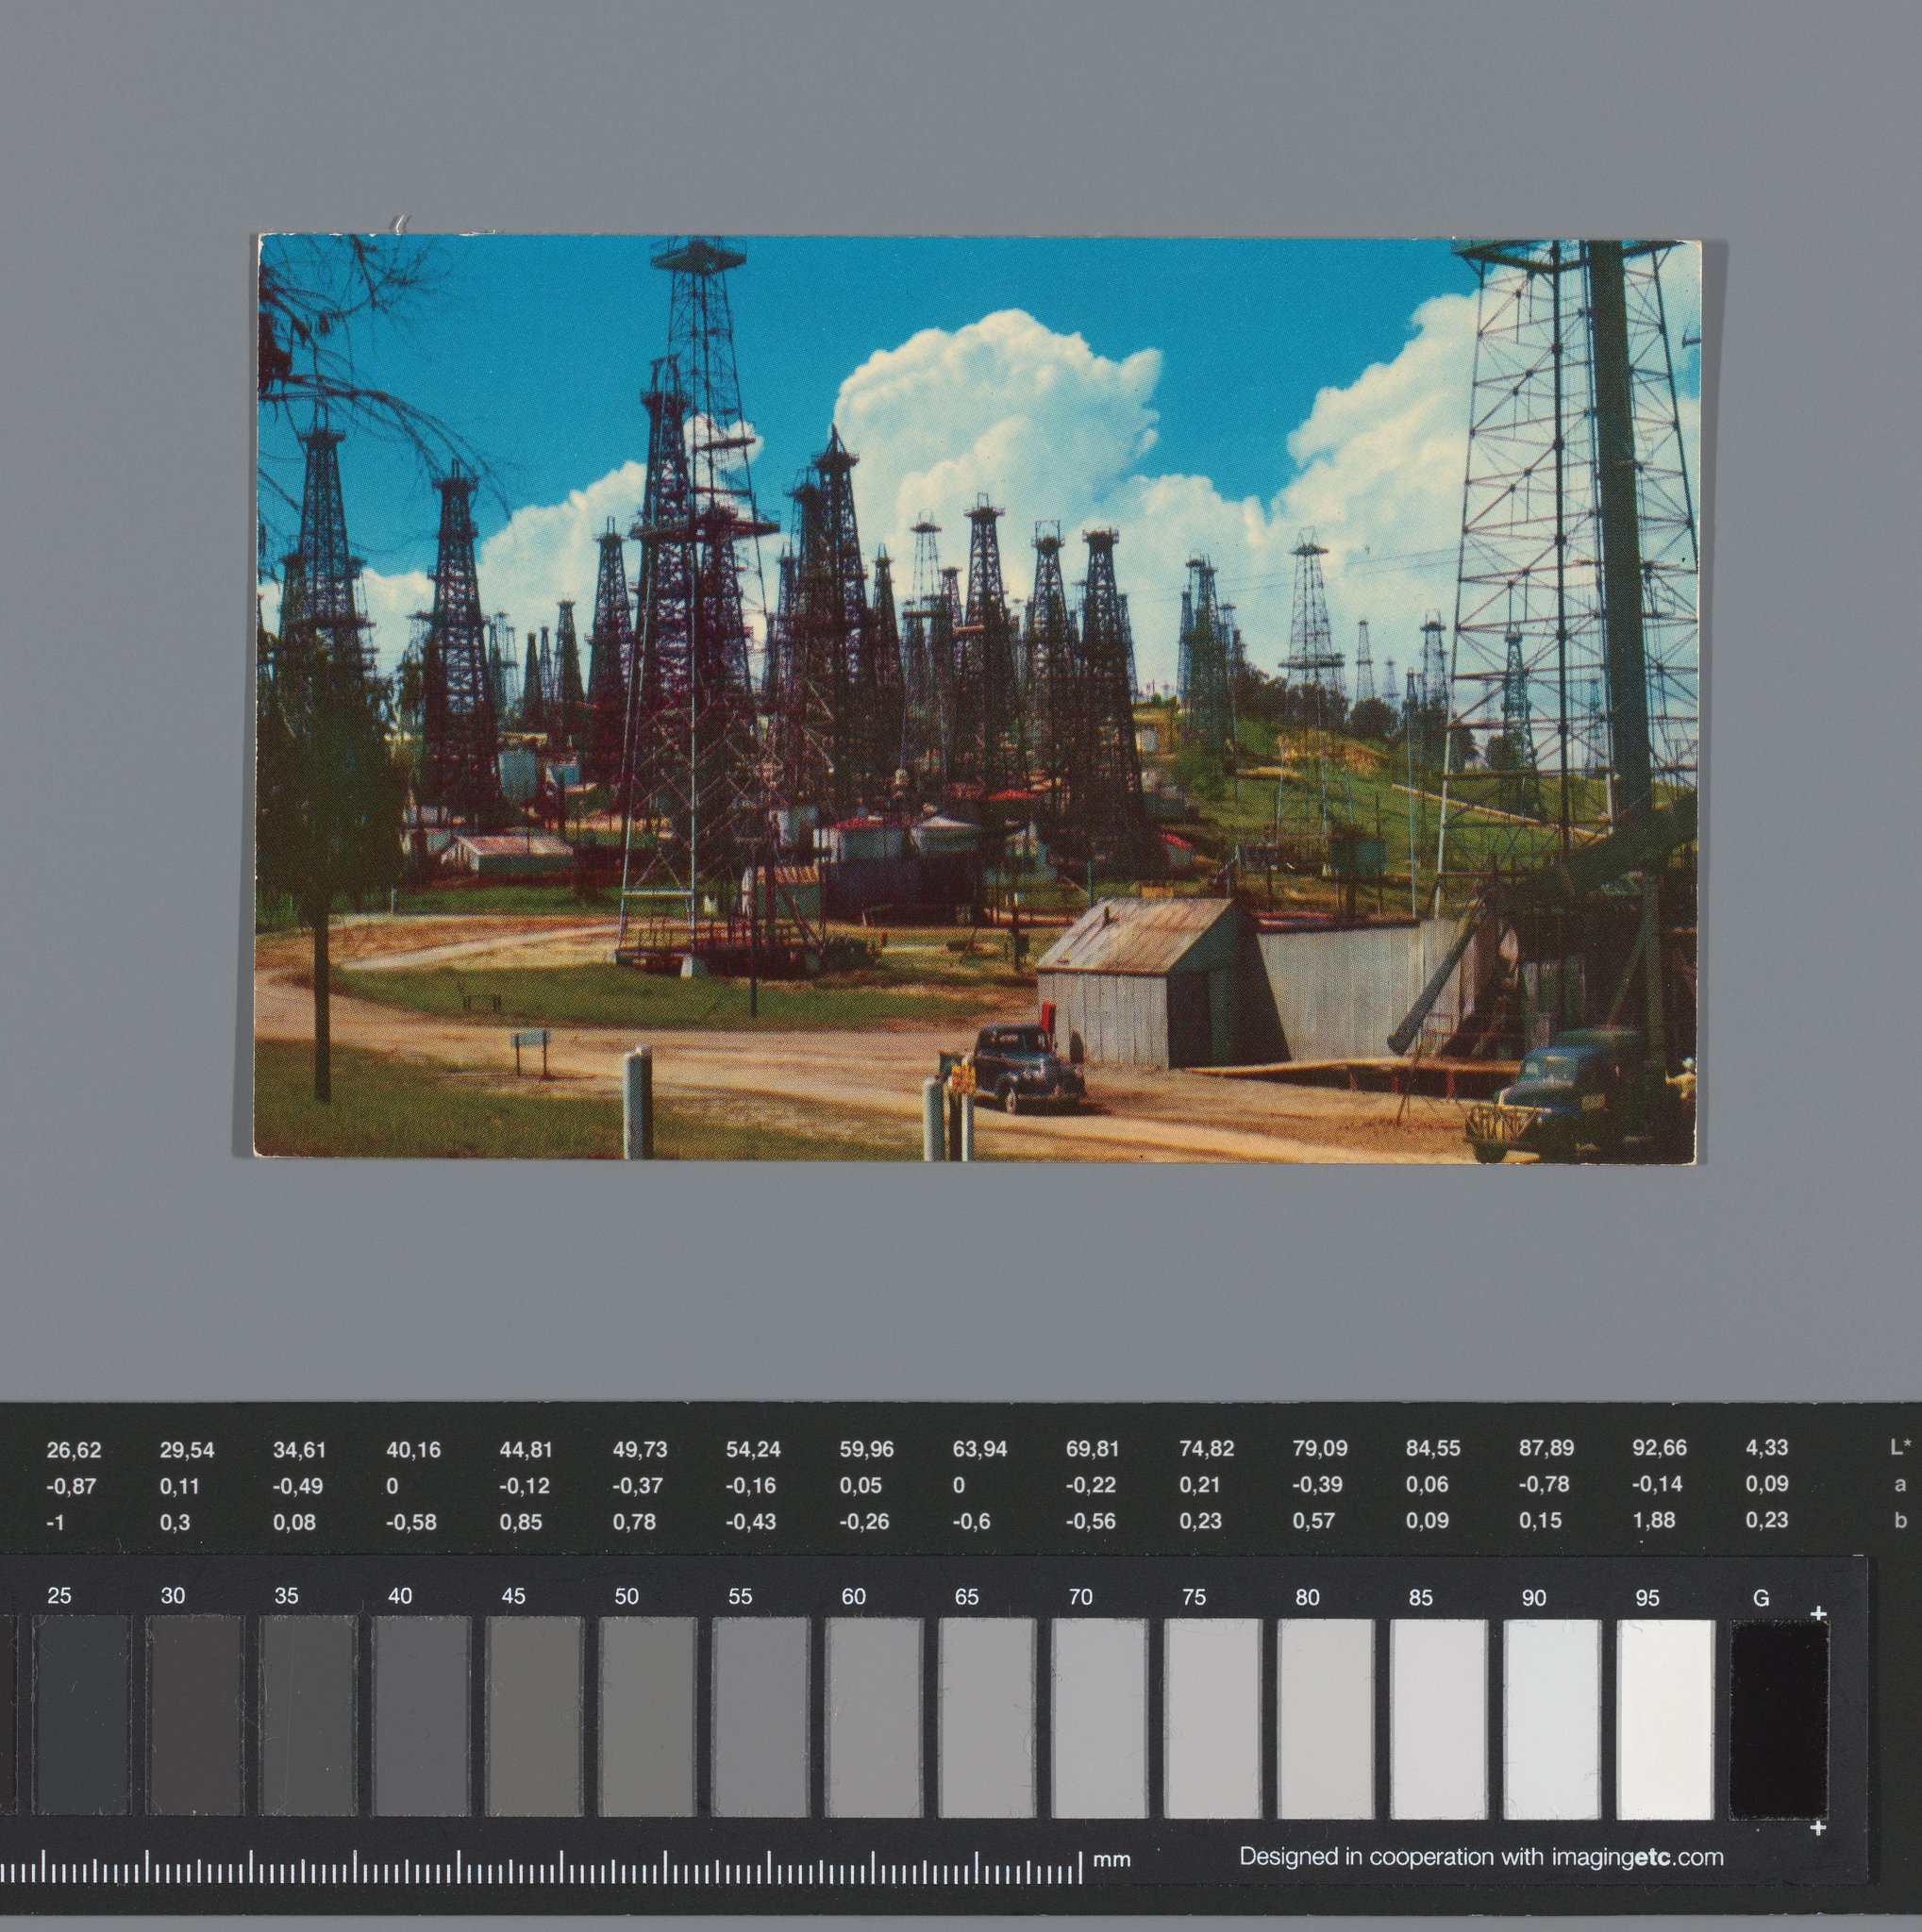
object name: ansichtkaart, prentbriefkaart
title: Olieveld in Signal Hill, Long Beach, Californië met boortorens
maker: Anonymous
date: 1945-1960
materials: paper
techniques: autotype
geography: united states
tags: long beach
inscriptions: inscription: ‘LONG BEACH, CALIFORNIA / Producing oil wells on world-famous Signal Hill / Long Beach, California. // PUBLISHED BY DROWN NEWS AGENCY, LONG BEACH, CALIFORNIA // MIRRO-KROME CARD BY H.S. CROCKER CO., INC., SAN FRANCISCO 1, CALIF.’